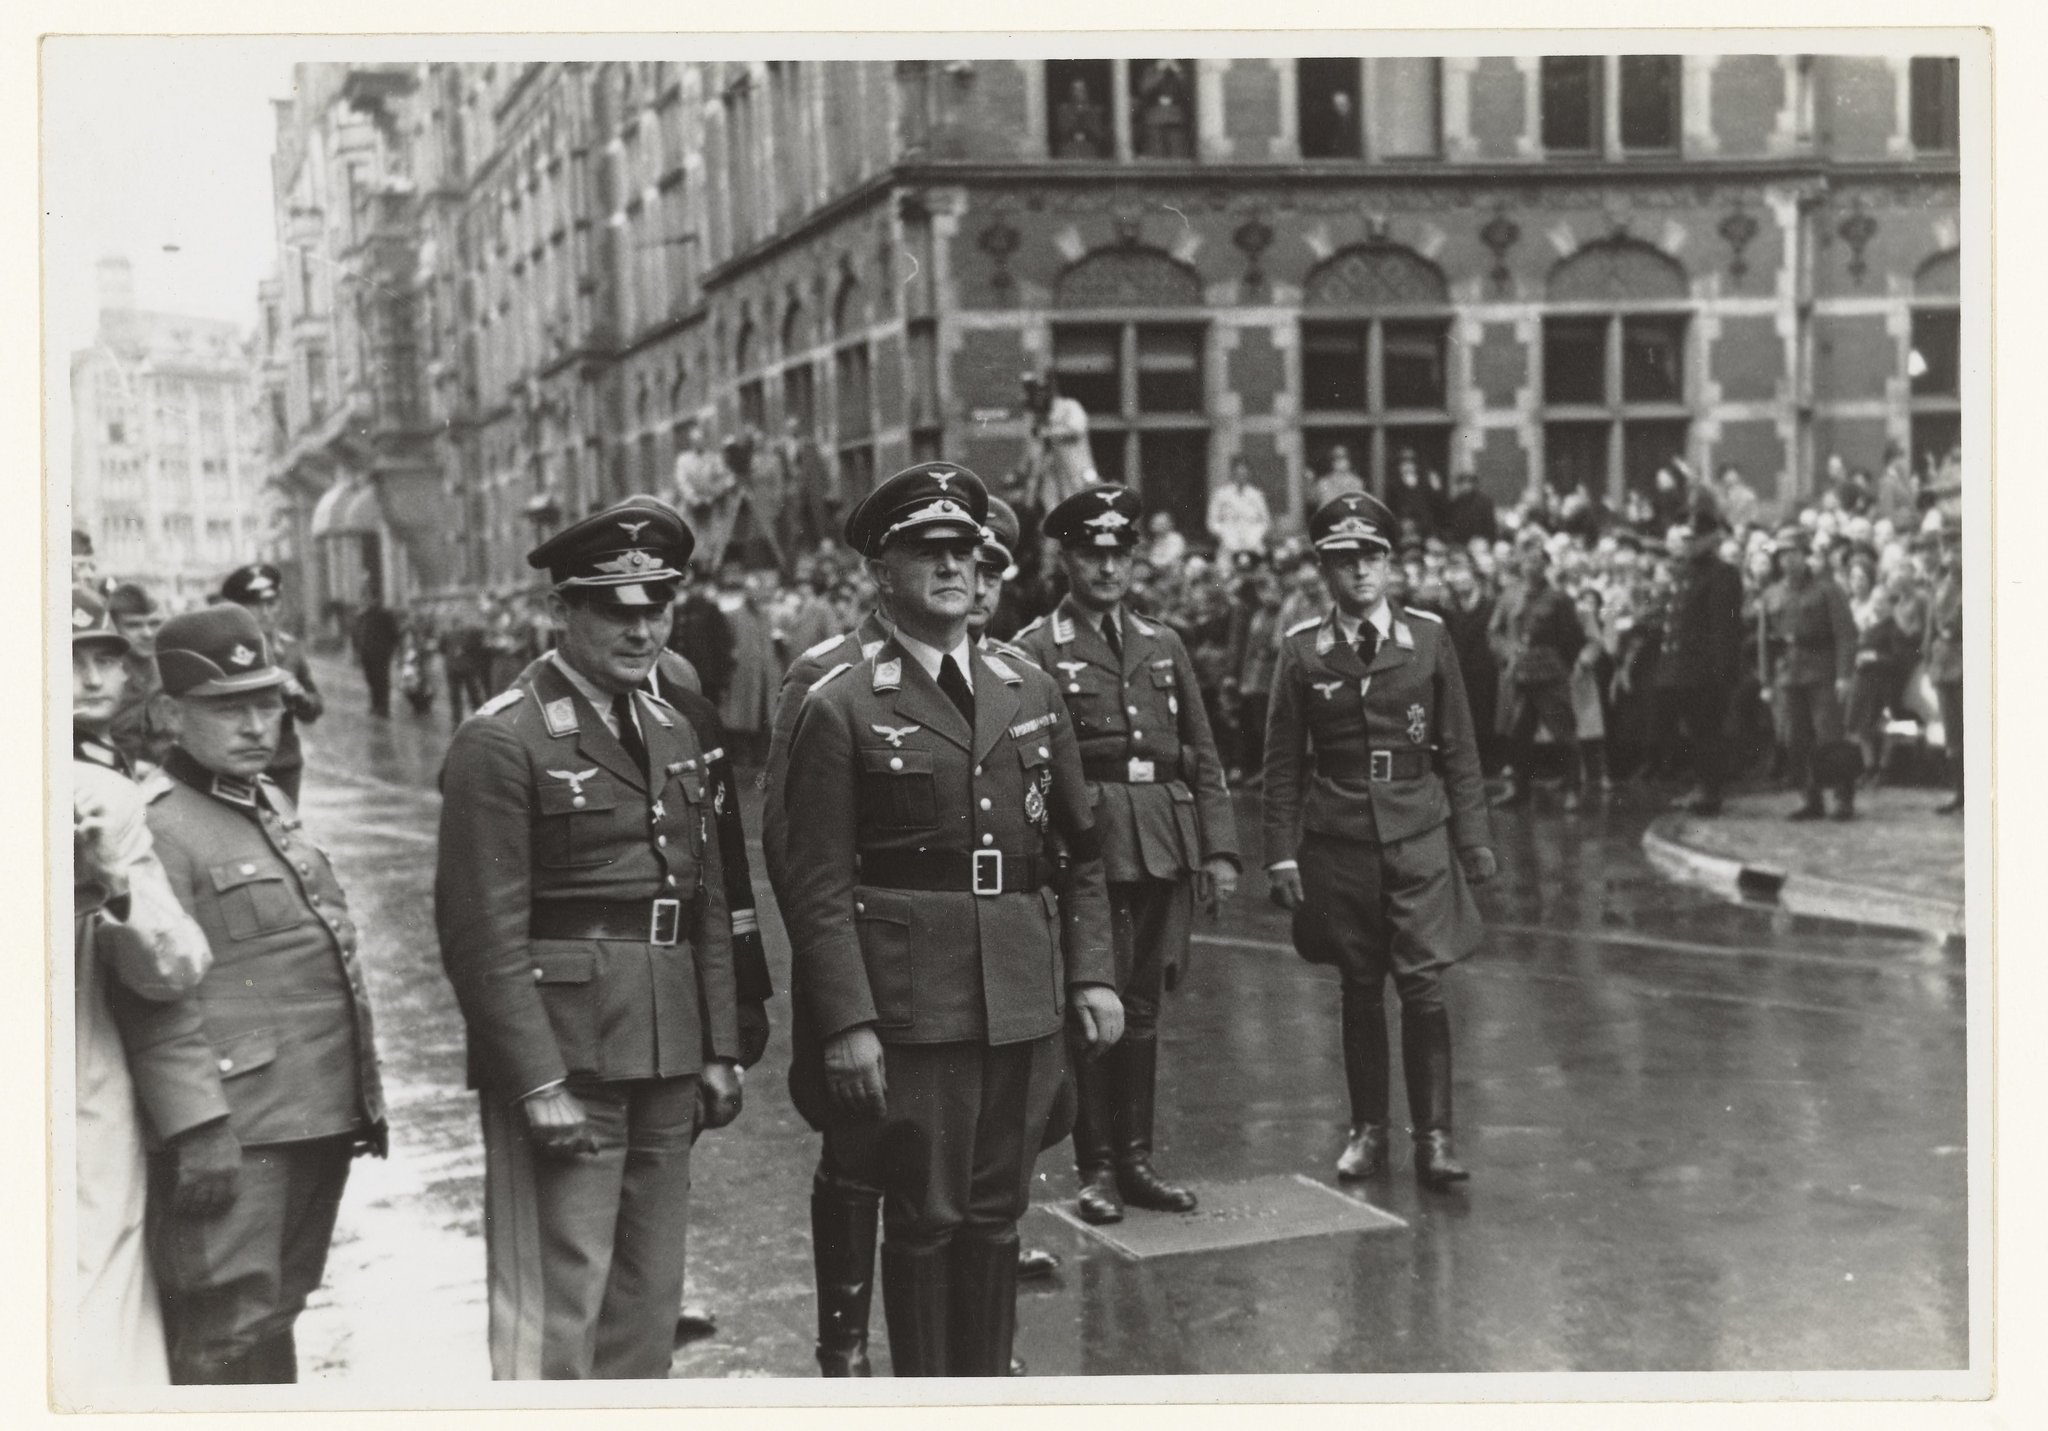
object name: photograph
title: Aankomst Oberbefehlshaber der Wehrmacht F. Christiansen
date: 1940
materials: photographic support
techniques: gelatin silver print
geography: the hague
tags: friedrich christiansen, military parade, pageant, the hague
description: General der Flieger en Oberbefehlshaber der Wehrmacht Friedrich Christiansen (derde van links) arriveert in Den Haag op de Lange Poten in gezelschap van een aantal hoge Duitse officieren. Op de achtergrond toeschouwers en fotografen. Hij bleef gedurende de oorlog de bevelhebber van de Wehrmacht in Nederland. Hij was ook degene die in 1944 opdracht gaf tot de razzia in Putten.